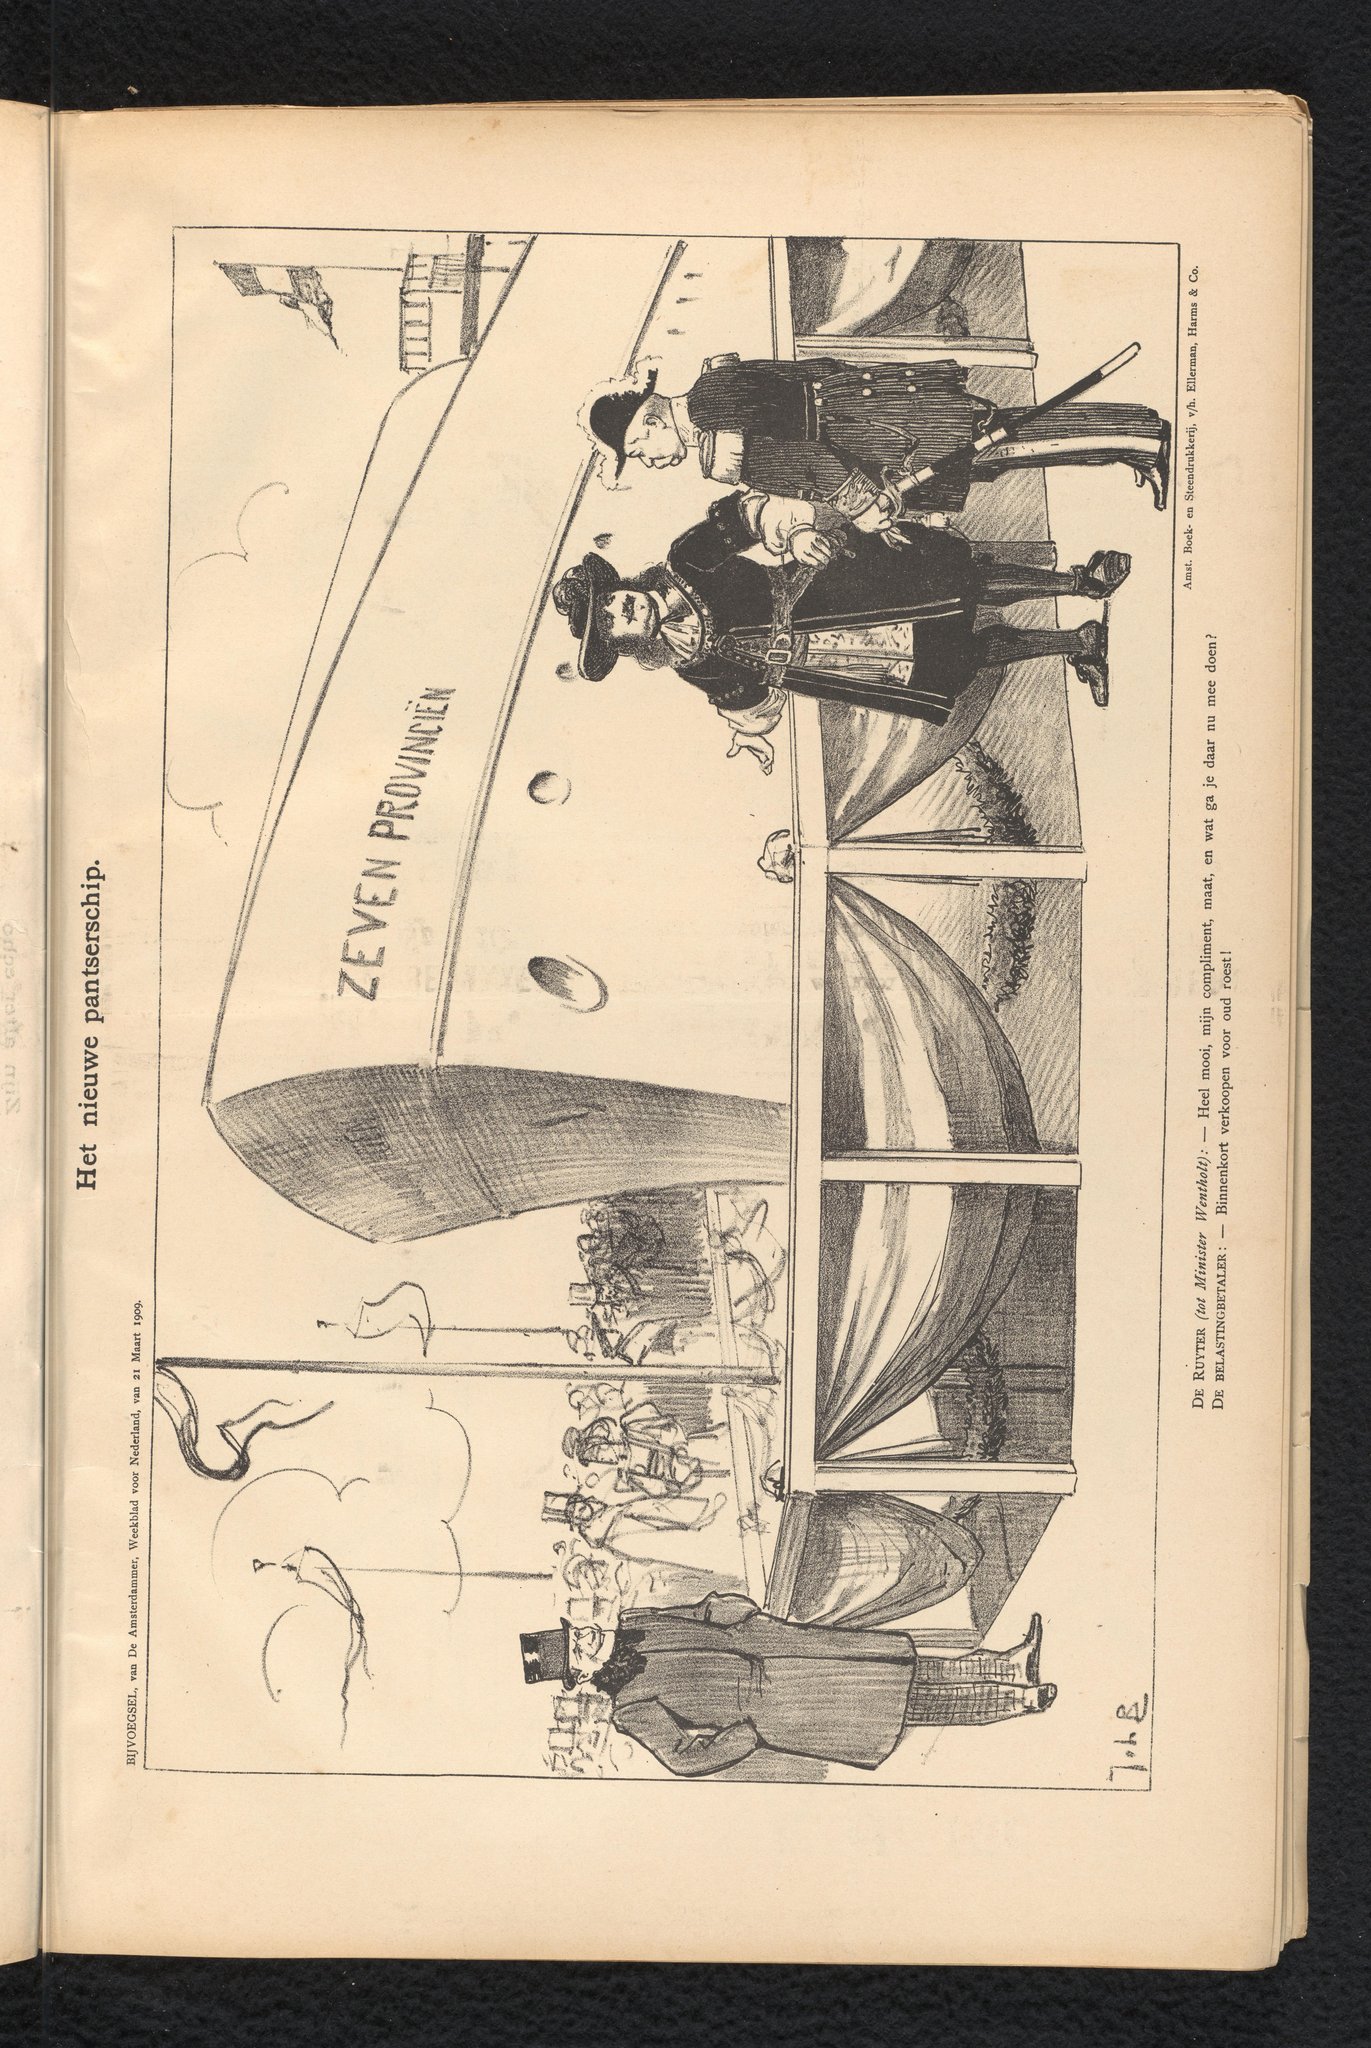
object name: cartoon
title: Het nieuwe pantserschip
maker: johan braakensiek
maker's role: draughtsman, print maker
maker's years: 1858-1940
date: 1909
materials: paper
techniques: lithograph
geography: amsterdam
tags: flushing, michiel adriaenszoon de ruyter, launching a ship, navy, political caricatures and satires, steamship, motorship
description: Admiraal Michiel Adriaenszoon de Ruyter complimenteert minister van Marine Jan Wentholt met het nieuwe pantserschip De Zeven Provinciën. Links de belastingbetaler die het zonde van het geld vindt.